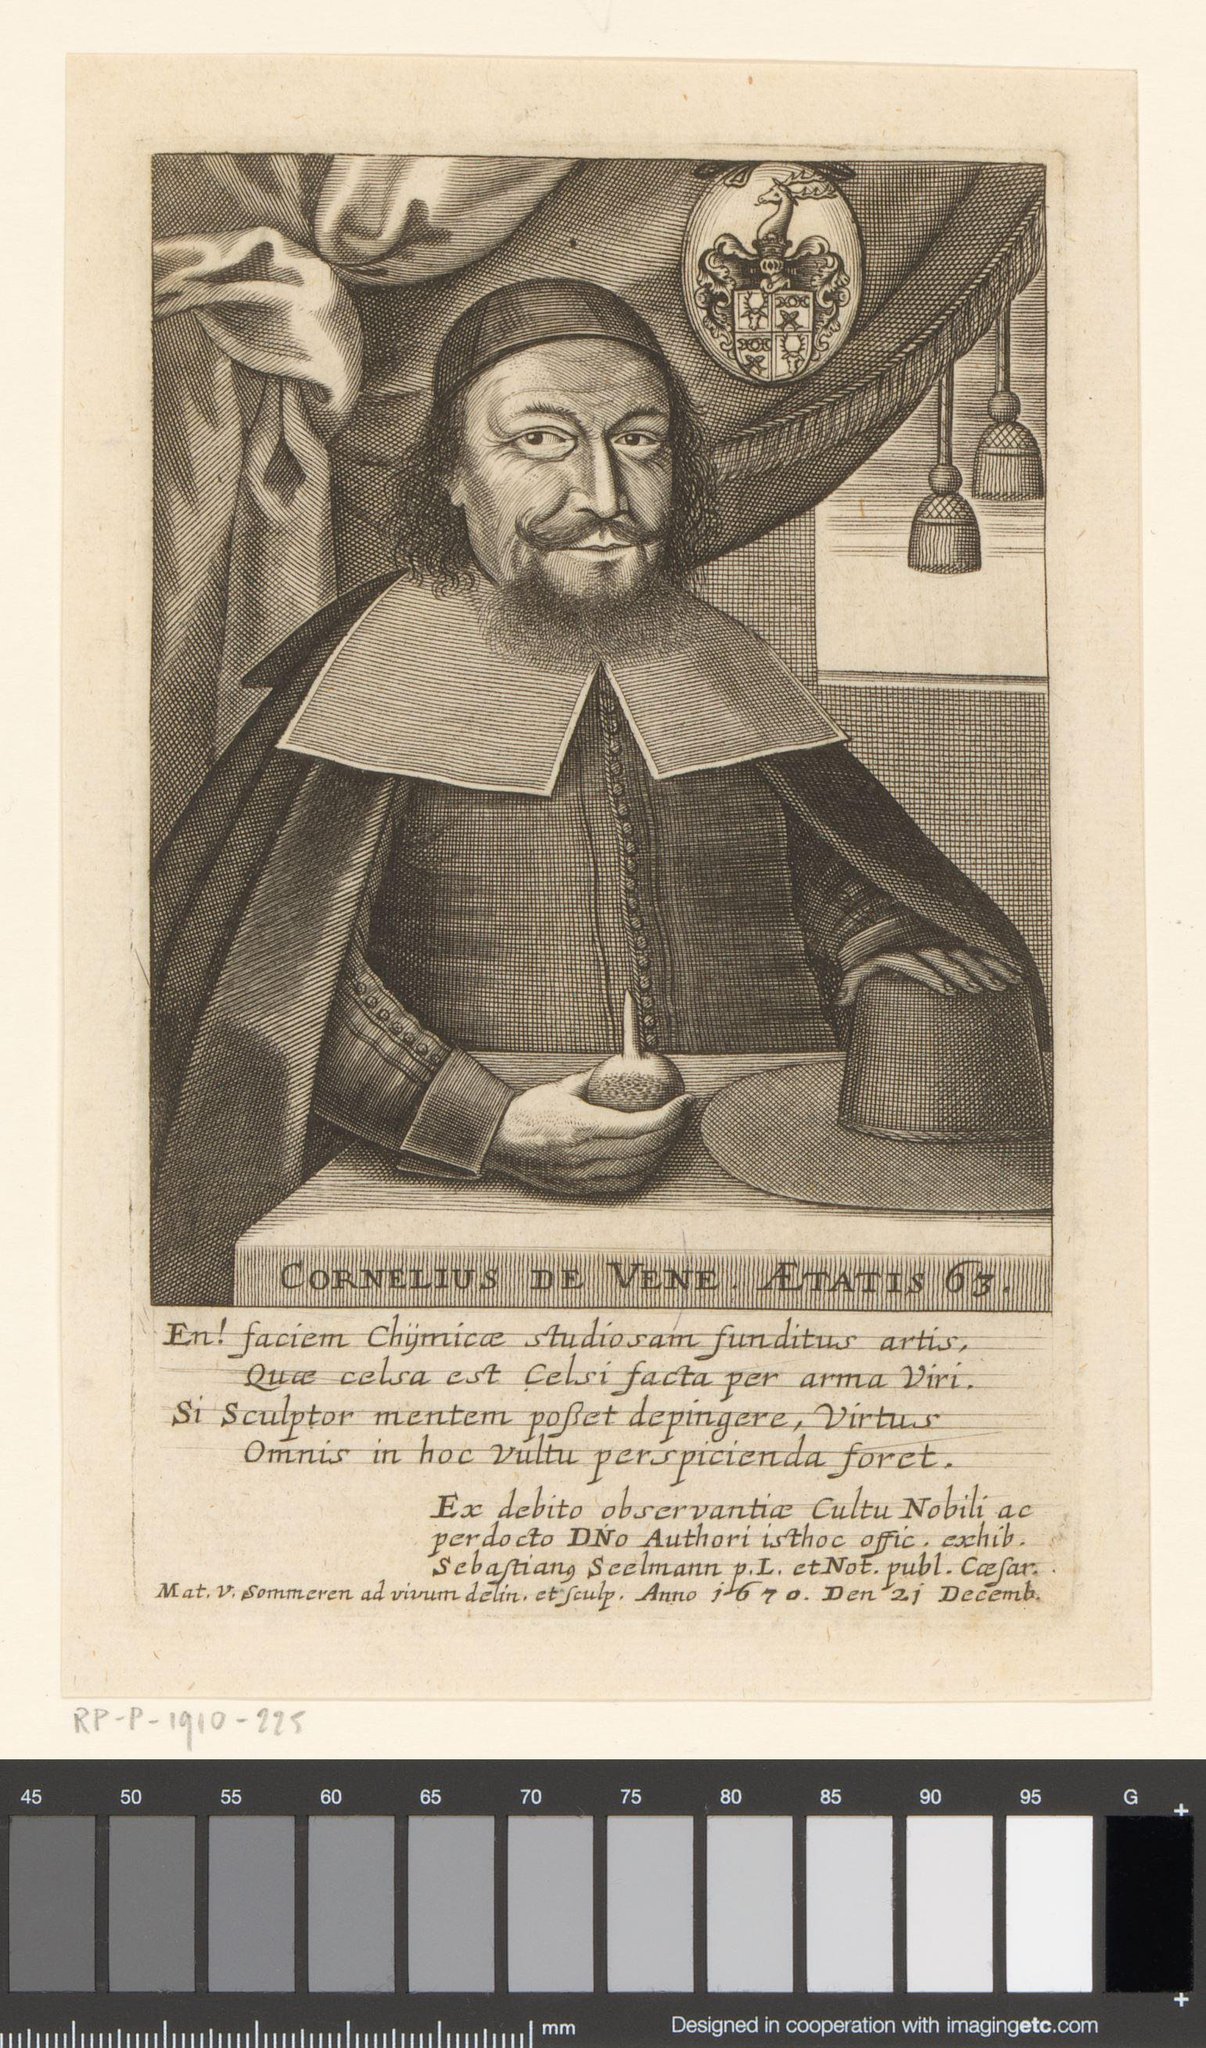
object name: print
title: Portret van Cornelius de Vene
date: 1670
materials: paper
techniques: engraving, etching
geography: germany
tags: historical persons, armorial bearing, heraldry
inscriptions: collector's mark: Lugt 2228